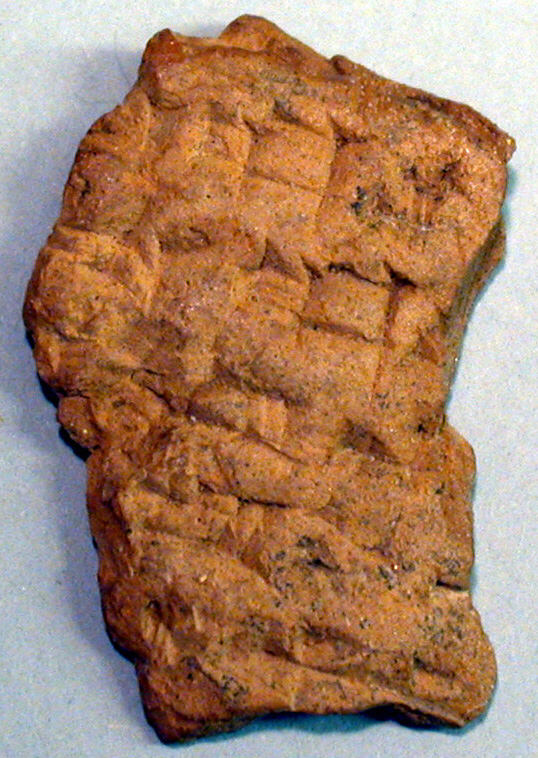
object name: cuneiform tablet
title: Cuneiform tablet: fragment of the witness list of a contract (?)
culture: achaemenid or babylonian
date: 700-301 BCE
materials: clay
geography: mesopotamia